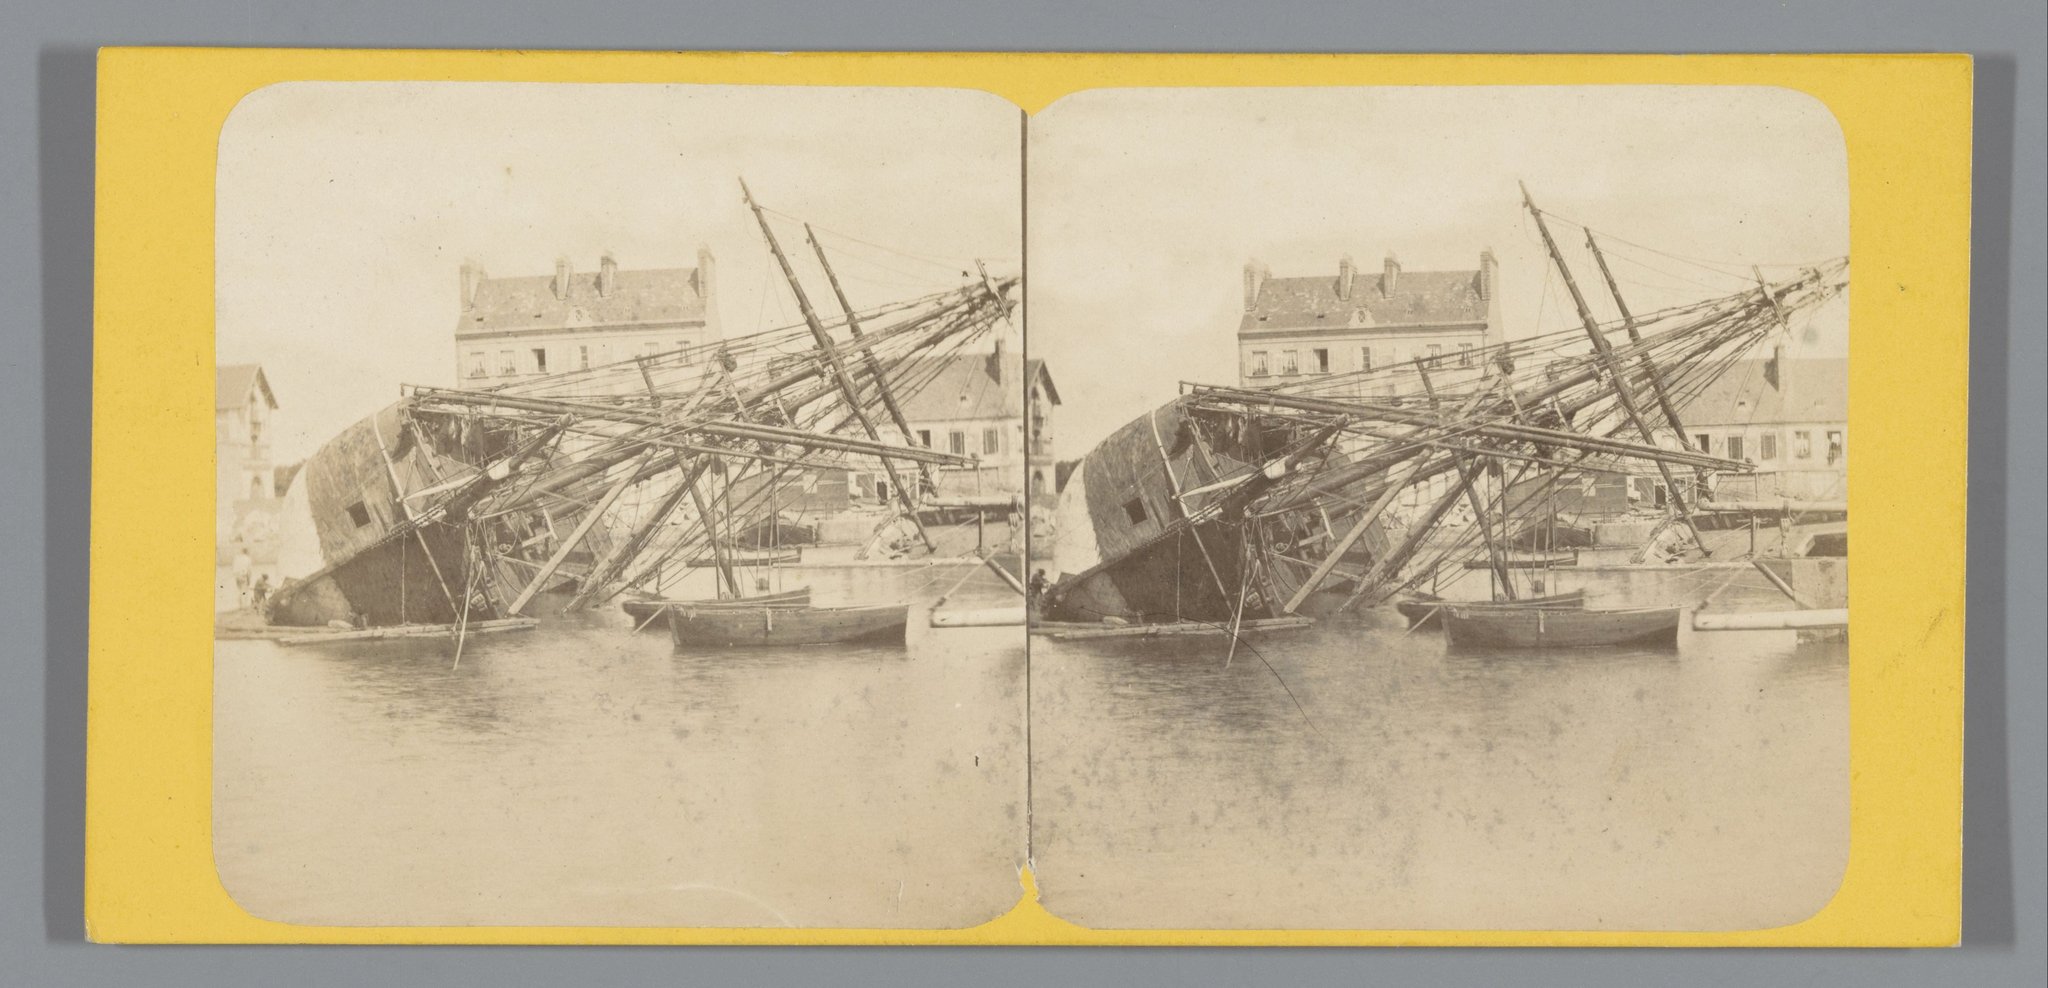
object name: stereograph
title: Cherbourg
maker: Anonymous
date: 1860-1880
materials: cardboard, photographic support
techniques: albumen print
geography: cherbourg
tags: ships (in general)